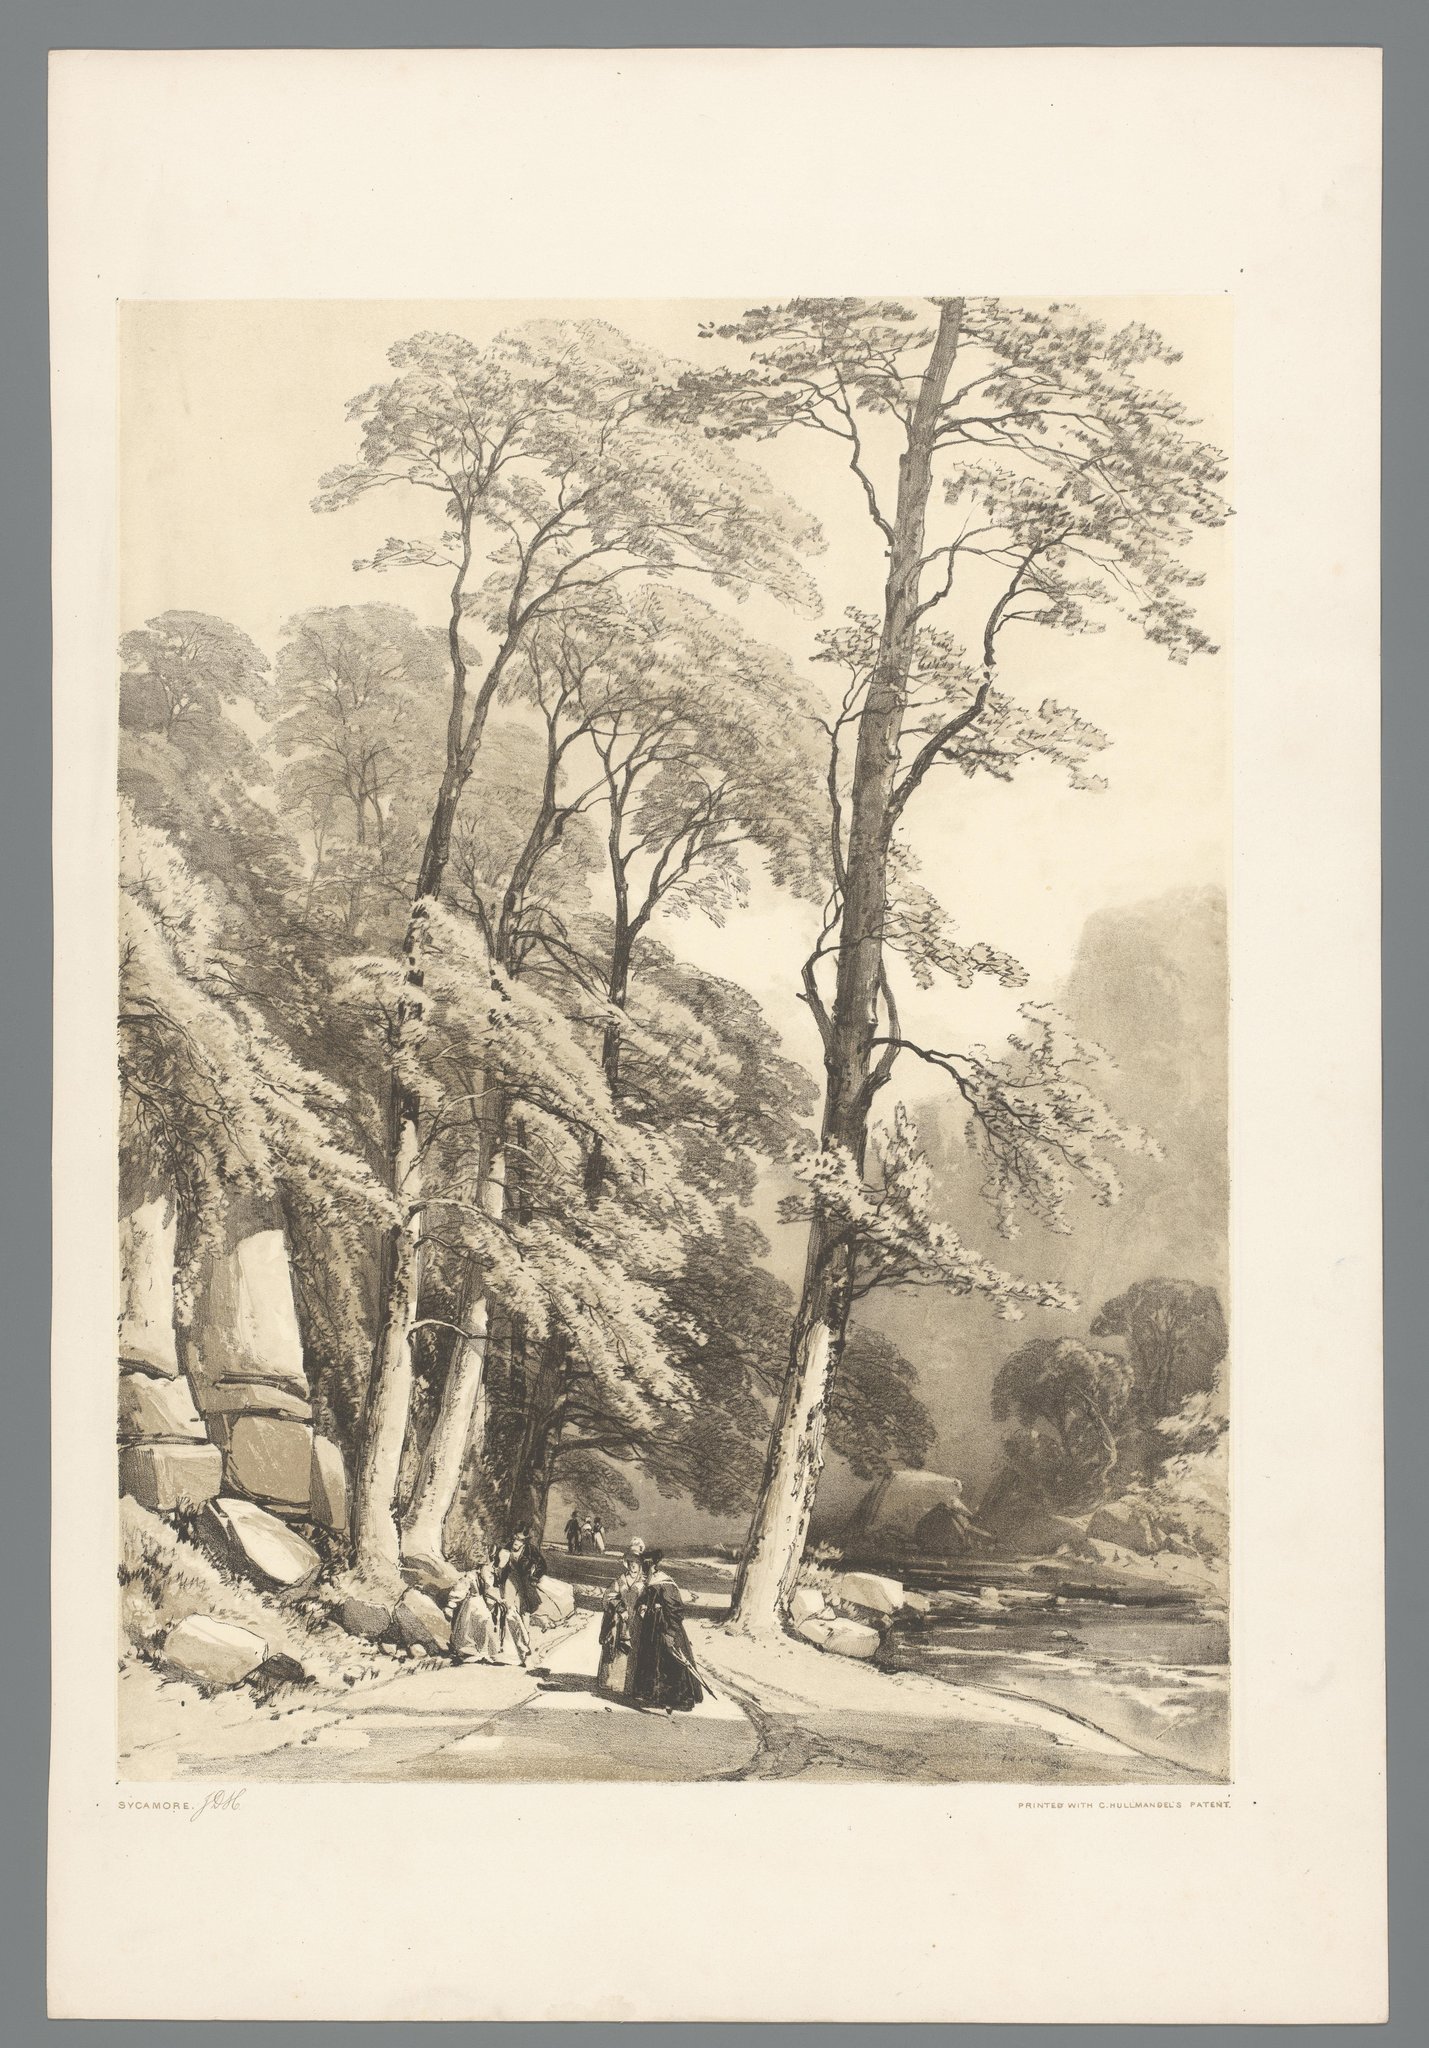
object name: print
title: Hoge bomen langs een bospad en een rivier in Rokeby Park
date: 1841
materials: paper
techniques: tone lithography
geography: london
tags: park, forest, wood, forest path or lane, river (+ landscape with figures, staffage)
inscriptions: collector's mark: Lugt 2228, collector's mark: Lugt 2760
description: Prent maakt deel uit van een serie van 24 prenten.